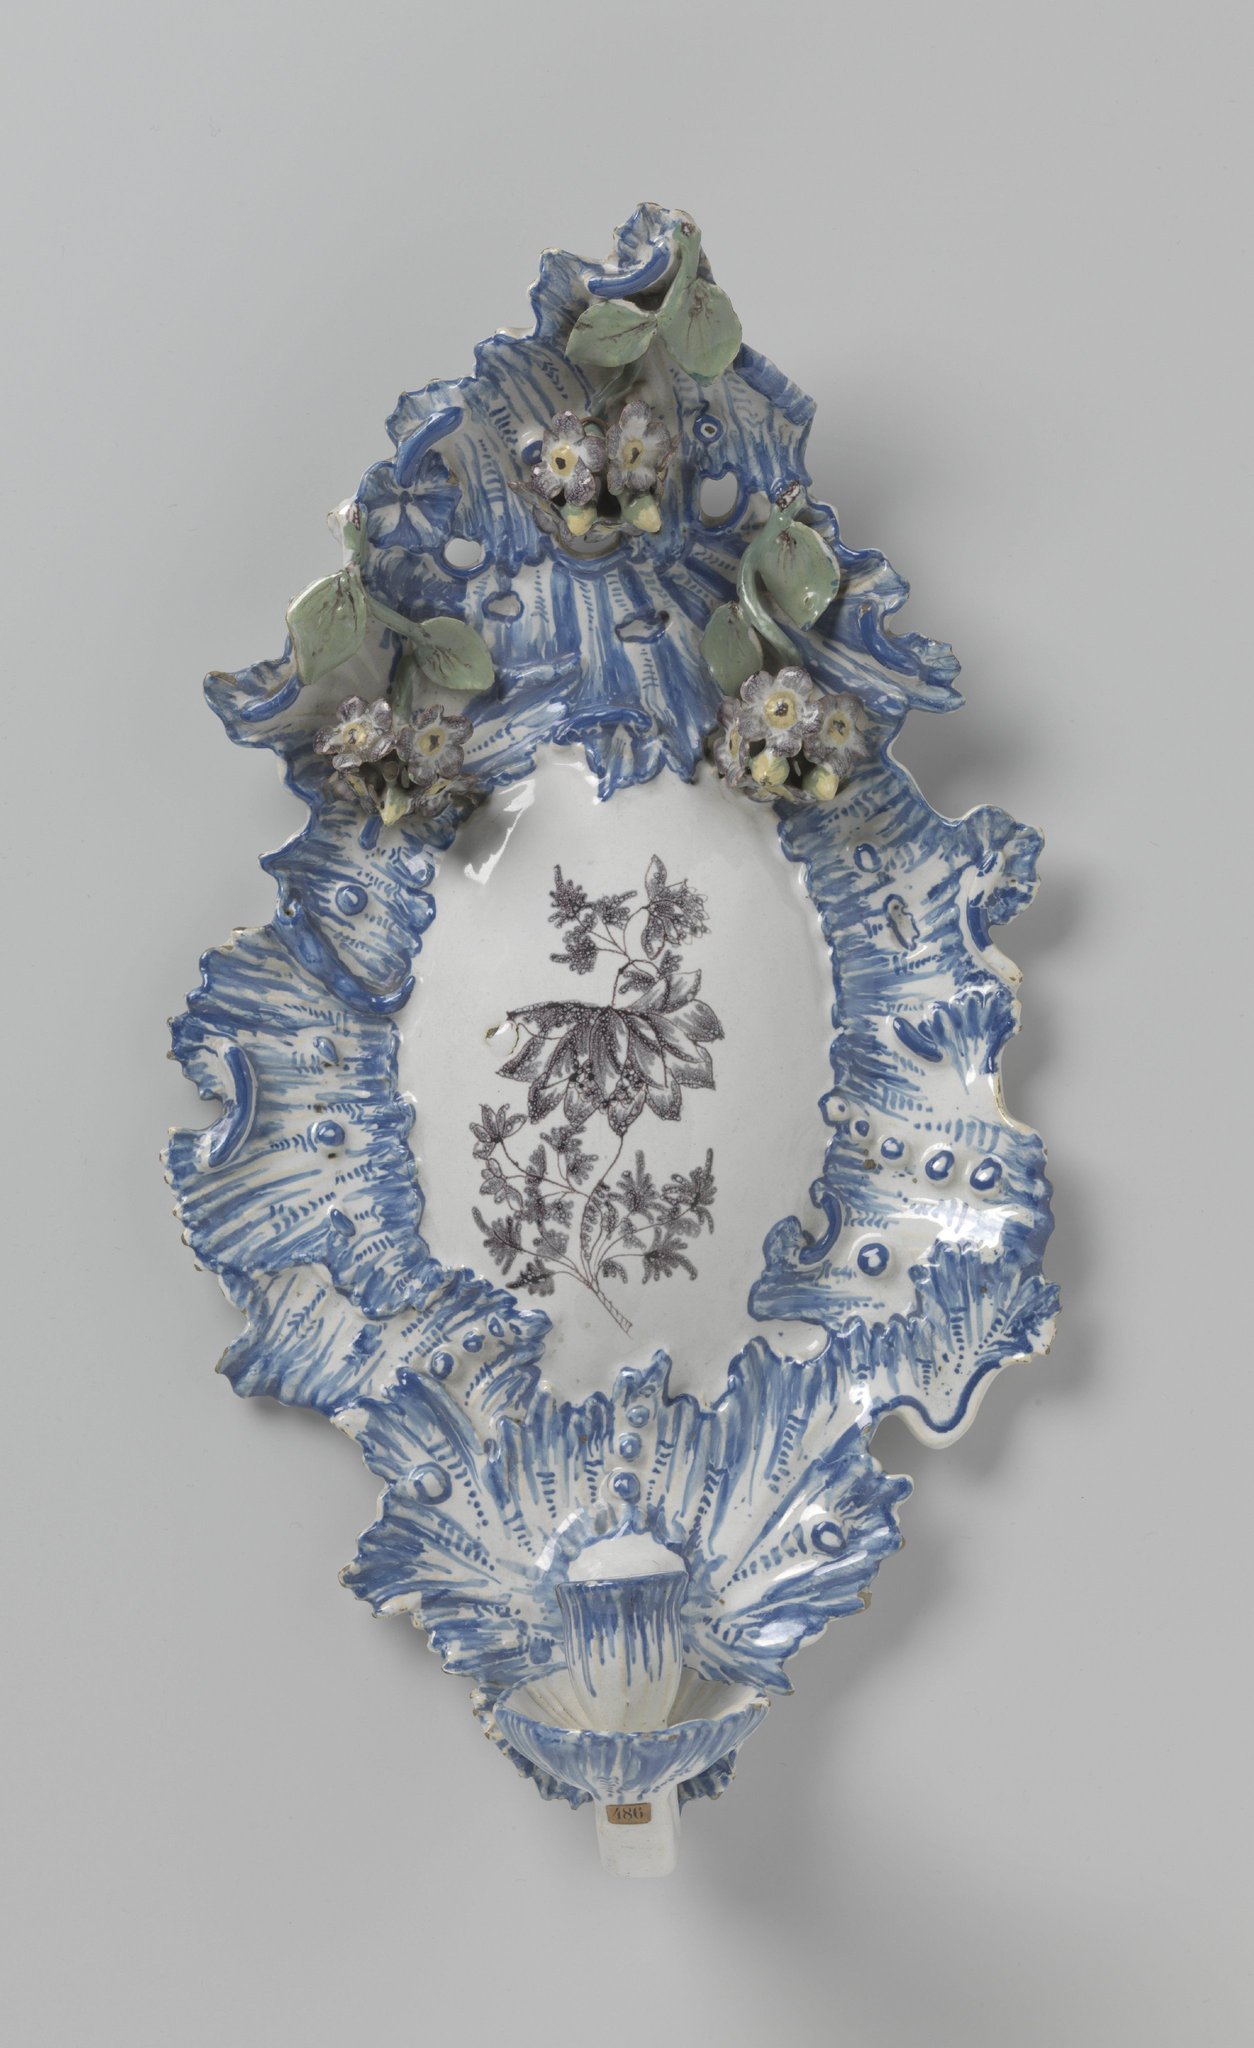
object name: sconce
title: Appliek, ovaal, met wandarm, veelkleurig beschilderd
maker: Anonymous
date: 1755-1770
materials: earthenware, glaze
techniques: painted, polychromy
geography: germany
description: Ovale wandarm van veelkleurig beschilderde faïence. Op het midden is een bloemenrank geschilderd met daar omheen een geschulpte rand met bloemen in relief. Aan de onderkant van de wandarm is een kaarsenhouder bevestigd.